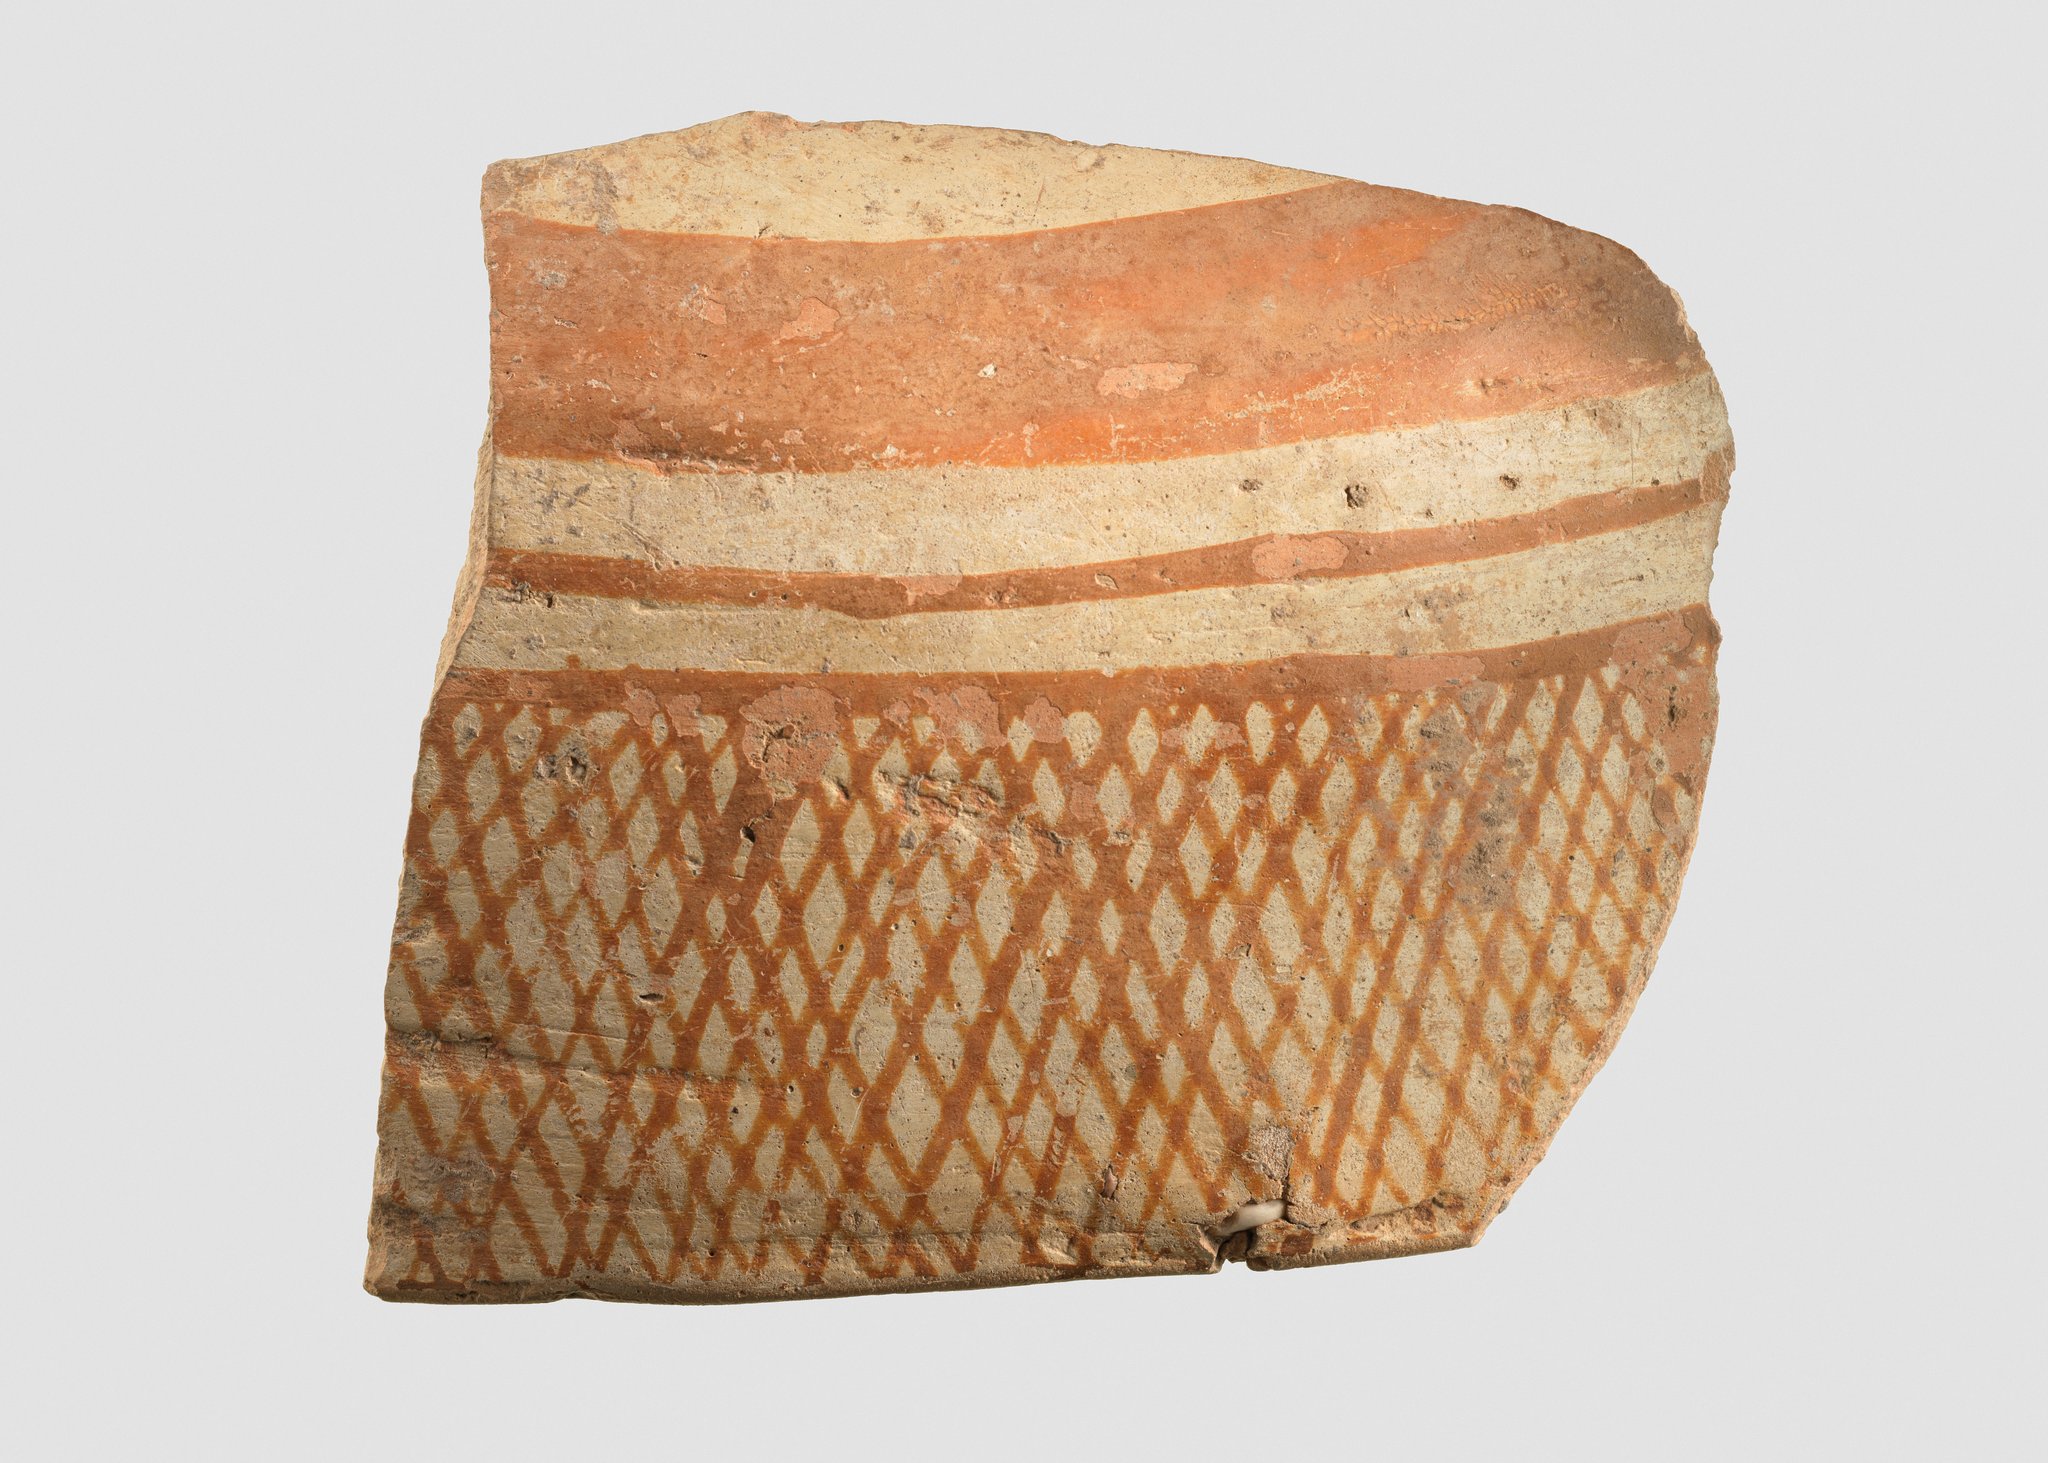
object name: sherd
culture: halaf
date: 4500 BCE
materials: ceramic, paint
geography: mesopotamia